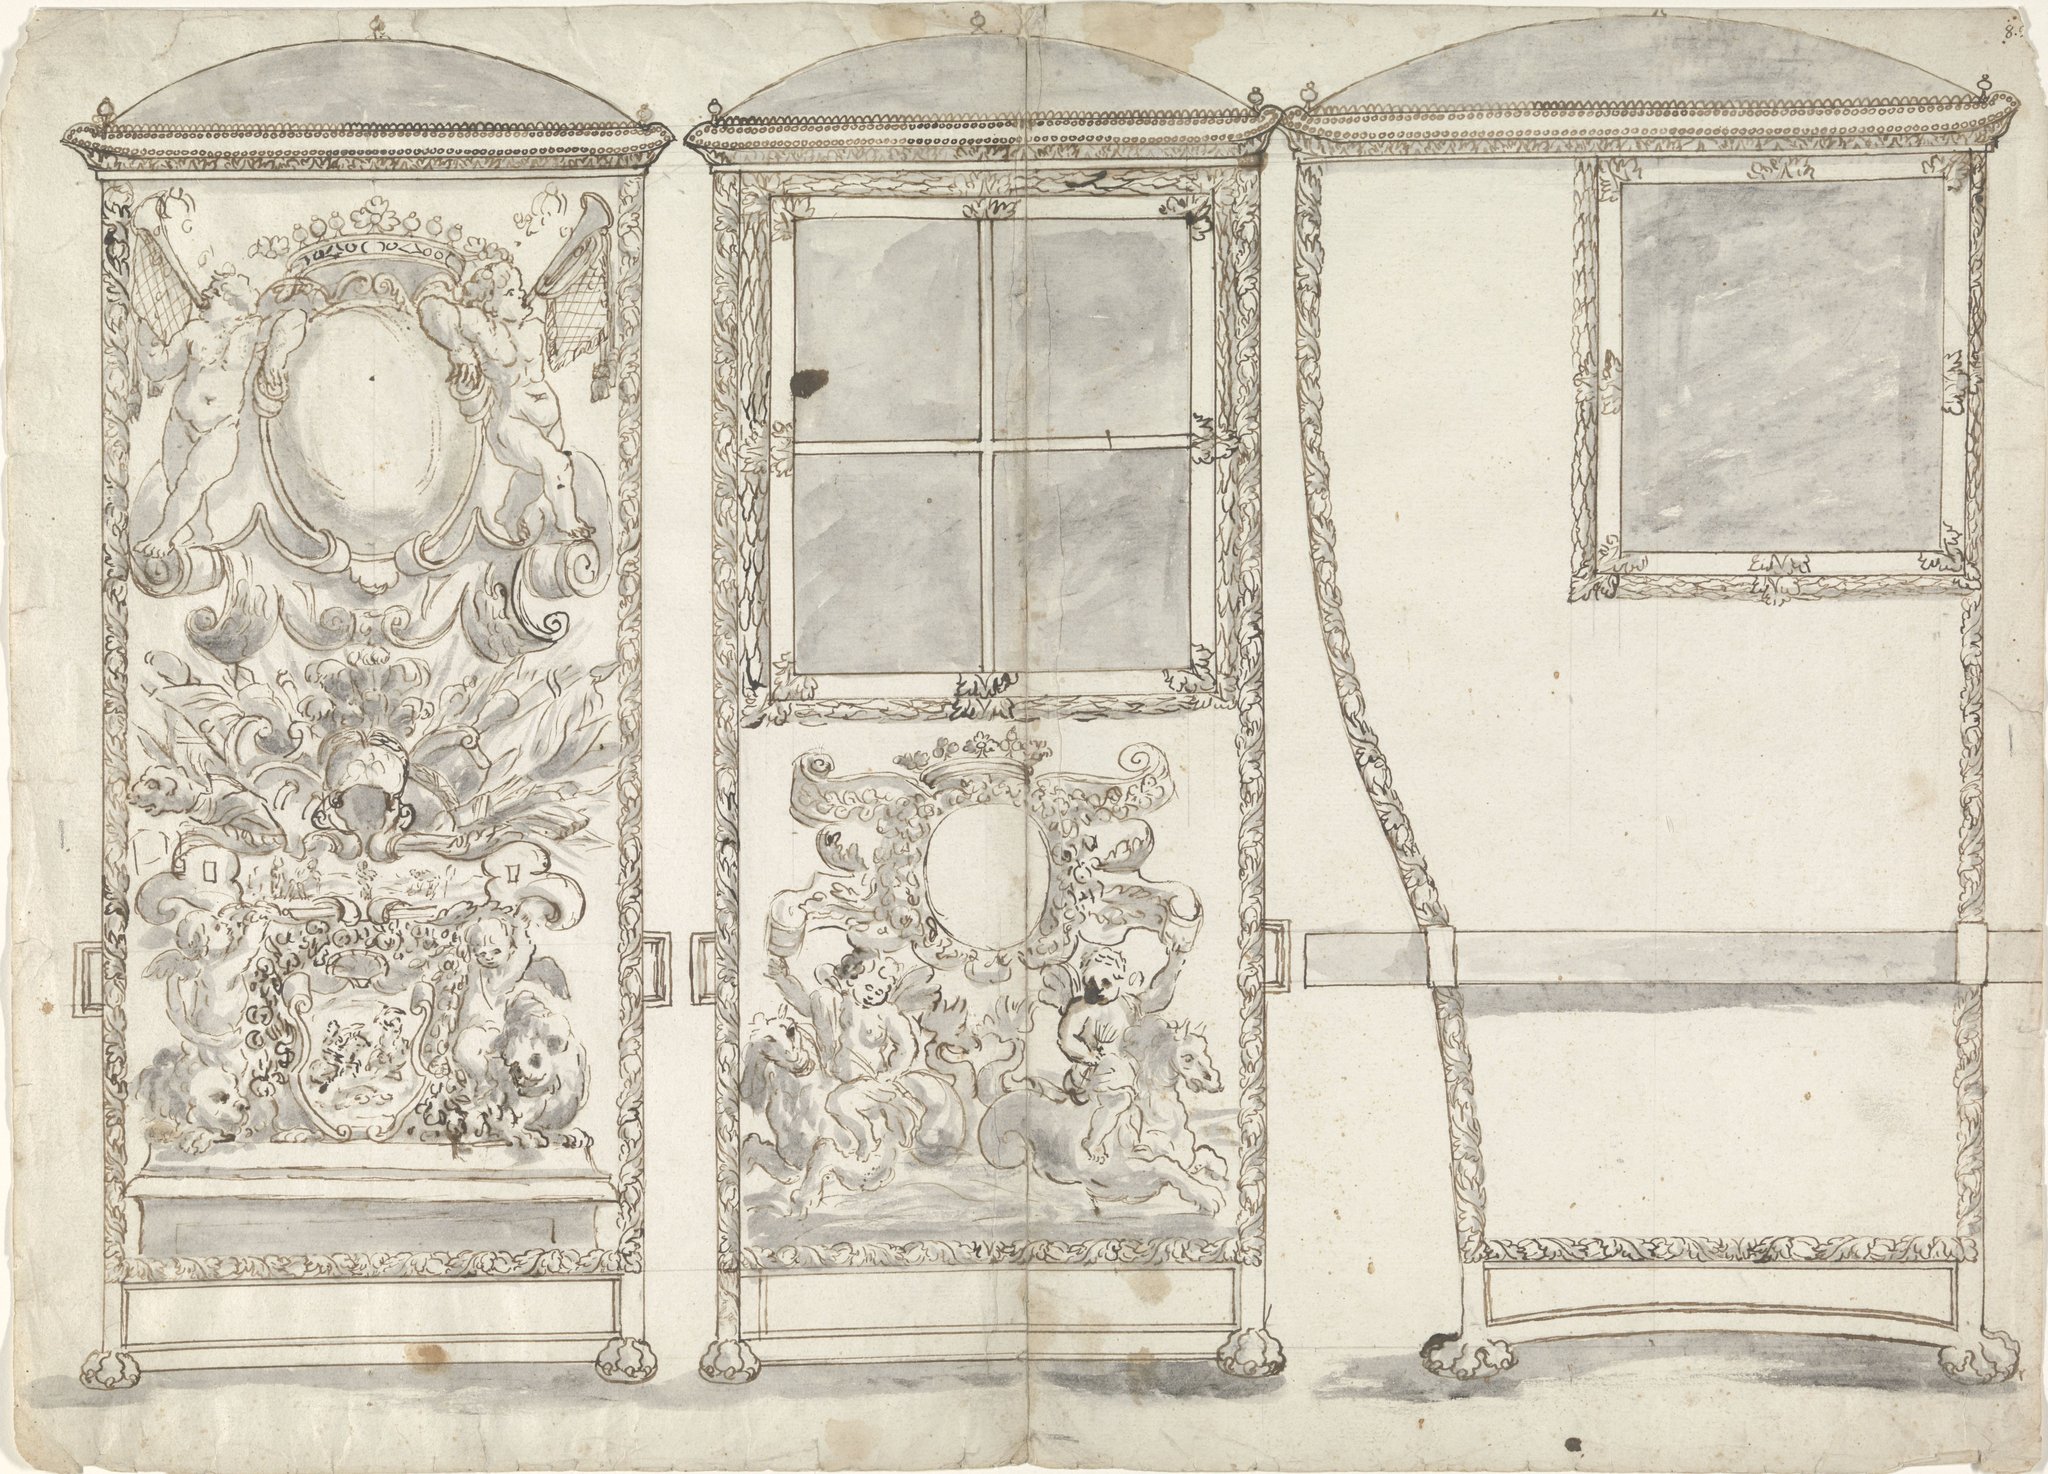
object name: design drawing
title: Design for a Sedan Chair, Viewed from the Back, the Front and the Right SIde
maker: Anonymous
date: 1650-1700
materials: ink, paper, watercolor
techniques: brush, pen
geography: france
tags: (carrying a person in a) sedan-chair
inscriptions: inscription: ‘29 / No 2’, inscription: ‘8.[2...]’, inscription: ‘Französische / Meister um 1700 / No. 3640/85’